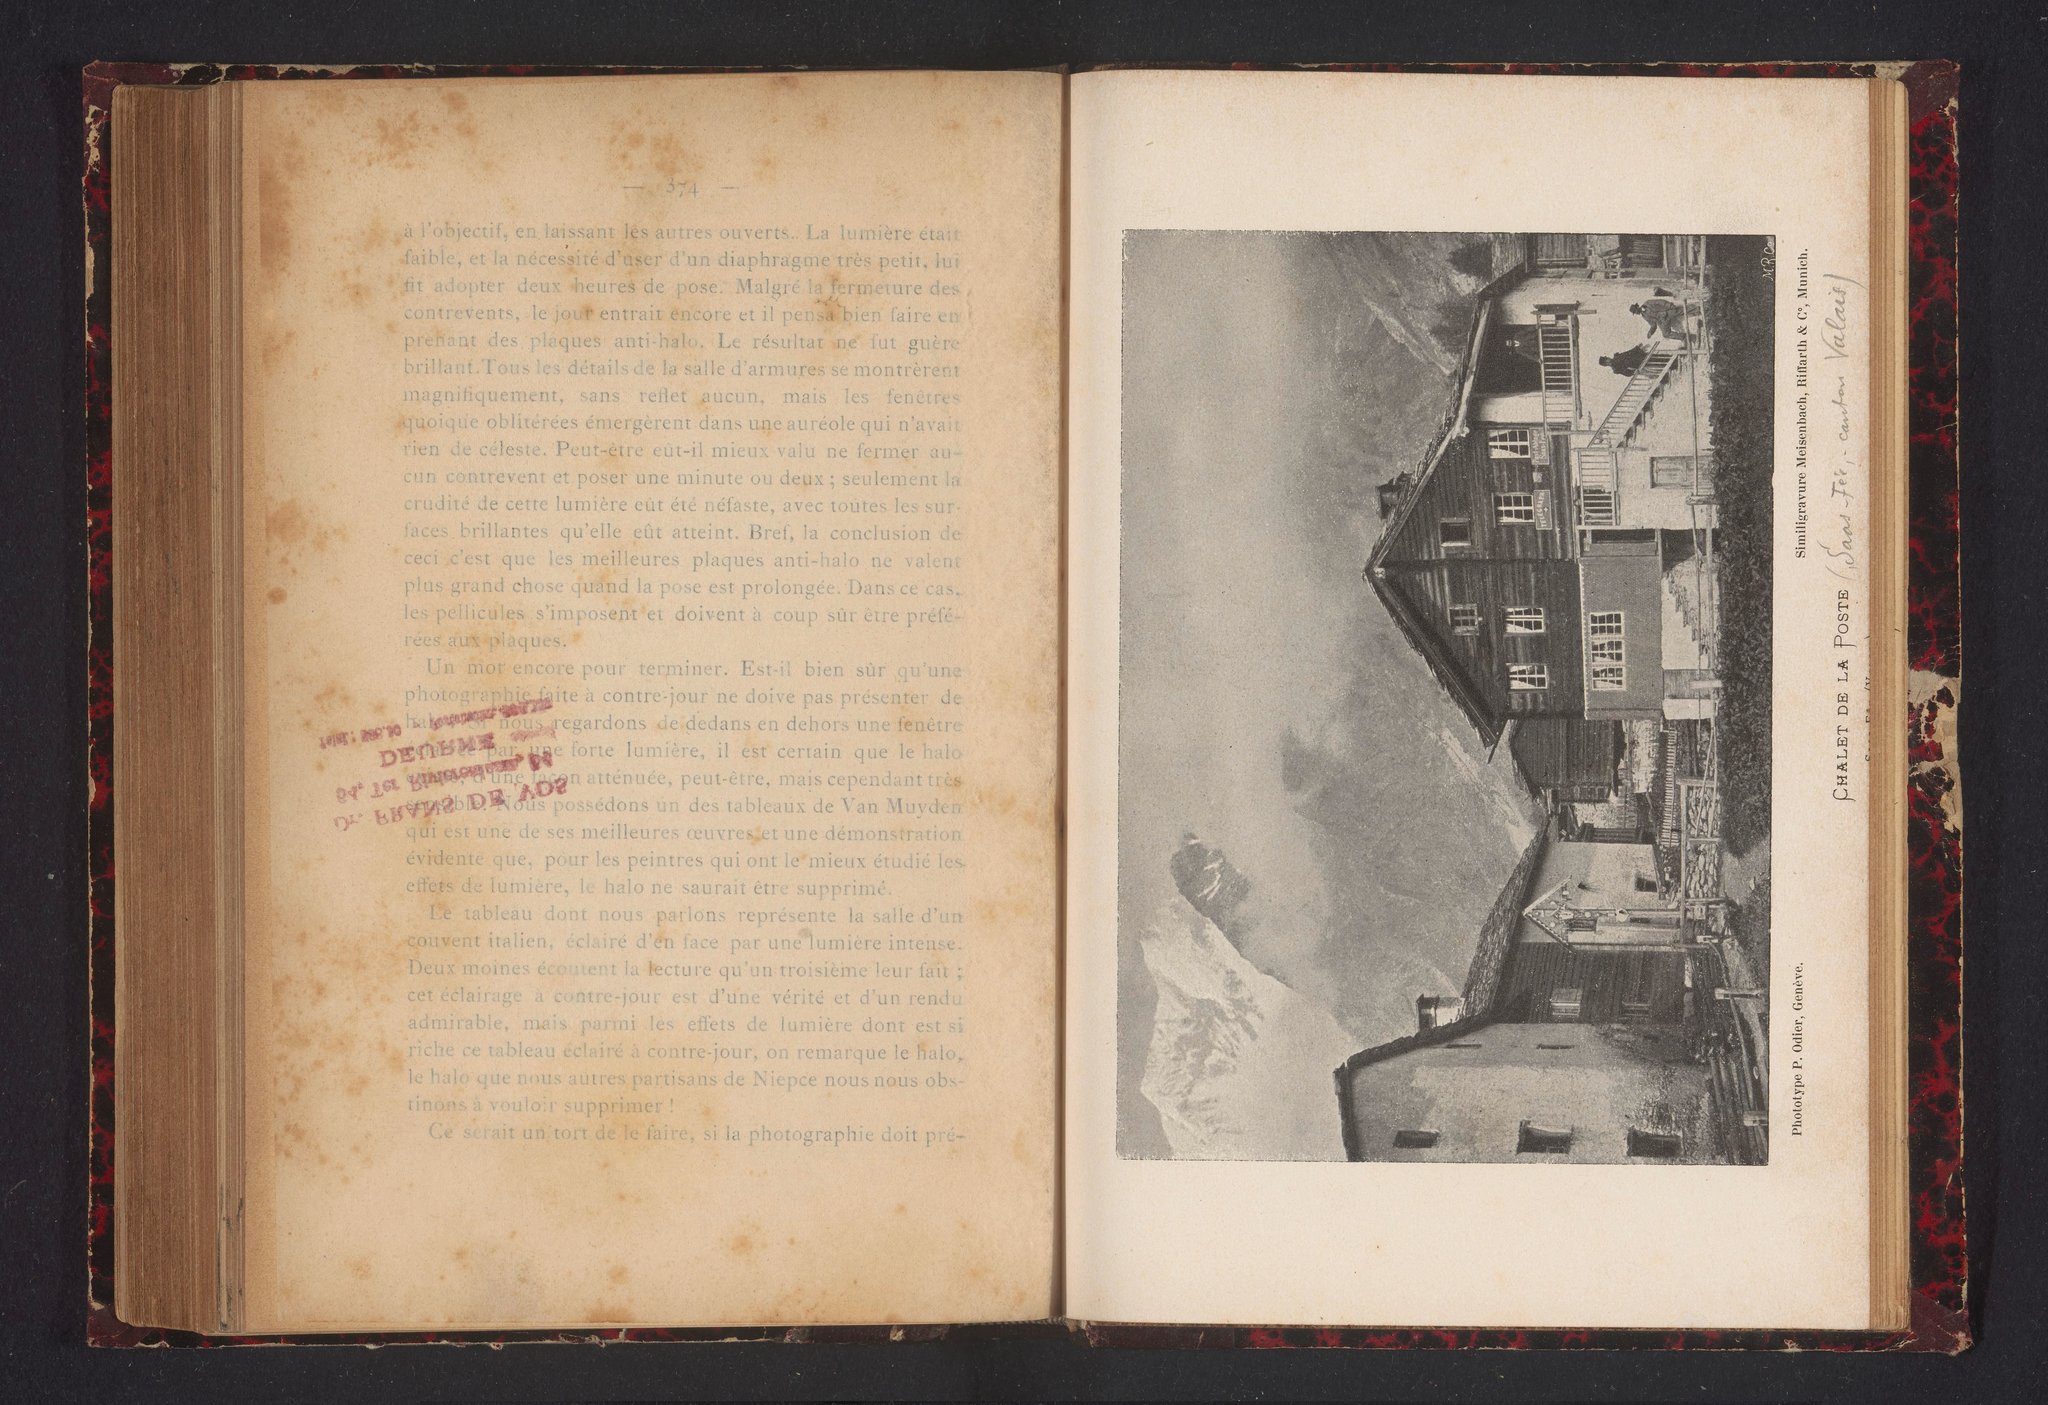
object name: photomechanical print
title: Gezicht op het postkantoor, vermoedelijk in Zwitserland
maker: p. odier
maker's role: fotograaf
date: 1894-1899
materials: paper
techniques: autotype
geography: munich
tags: post-office, mountains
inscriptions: annotation: ‘(Saas-Fee, canton Valais)’, inscription: ‘[...]’